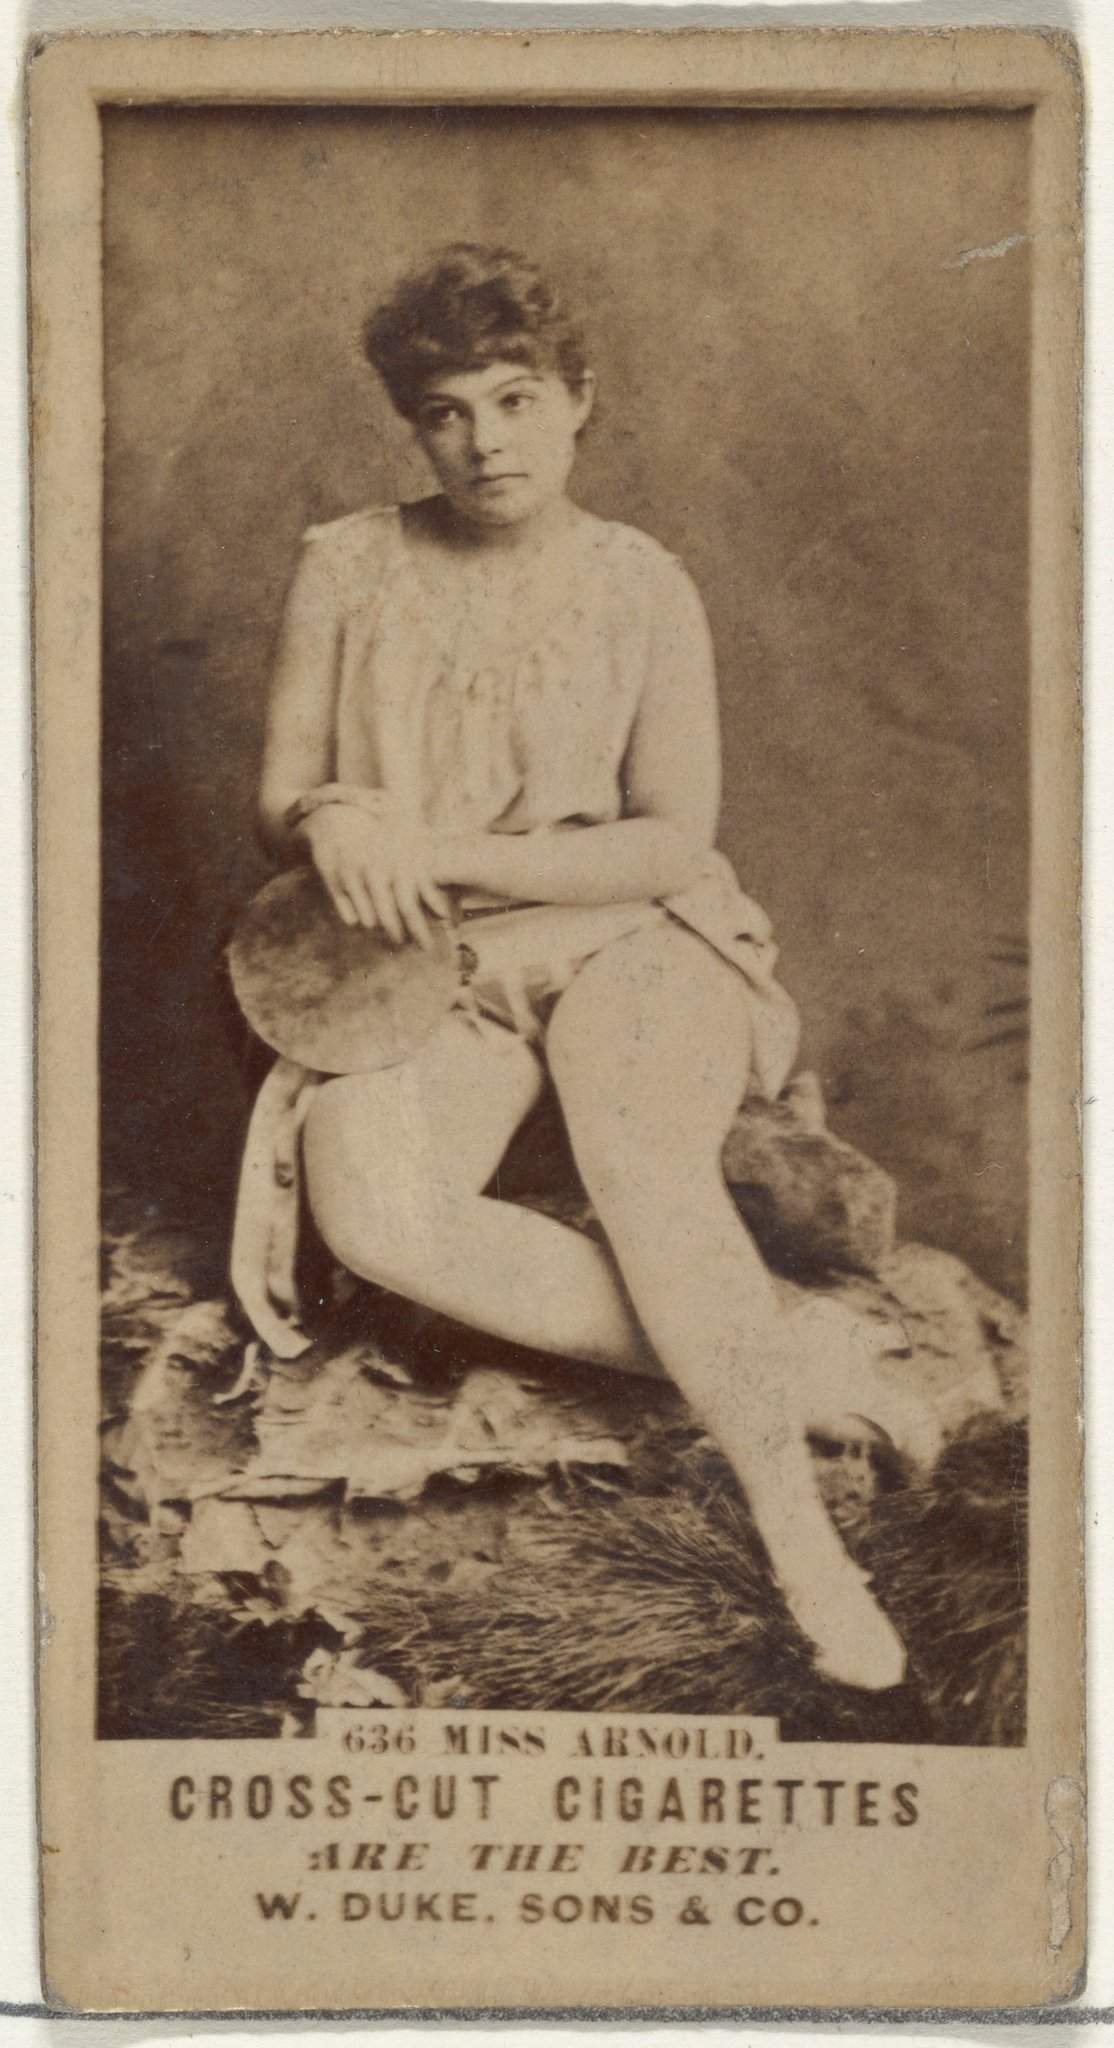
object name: photograph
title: Card Number 636, Miss Arnold, from the Actors and Actresses series (N145-3) issued by Duke Sons & Co. to promote Cross Cut Cigarettes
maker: w. duke, sons & co.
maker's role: publisher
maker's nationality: american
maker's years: 1870-1920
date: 1880-1889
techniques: albumen silver print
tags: portraits,women,actresses